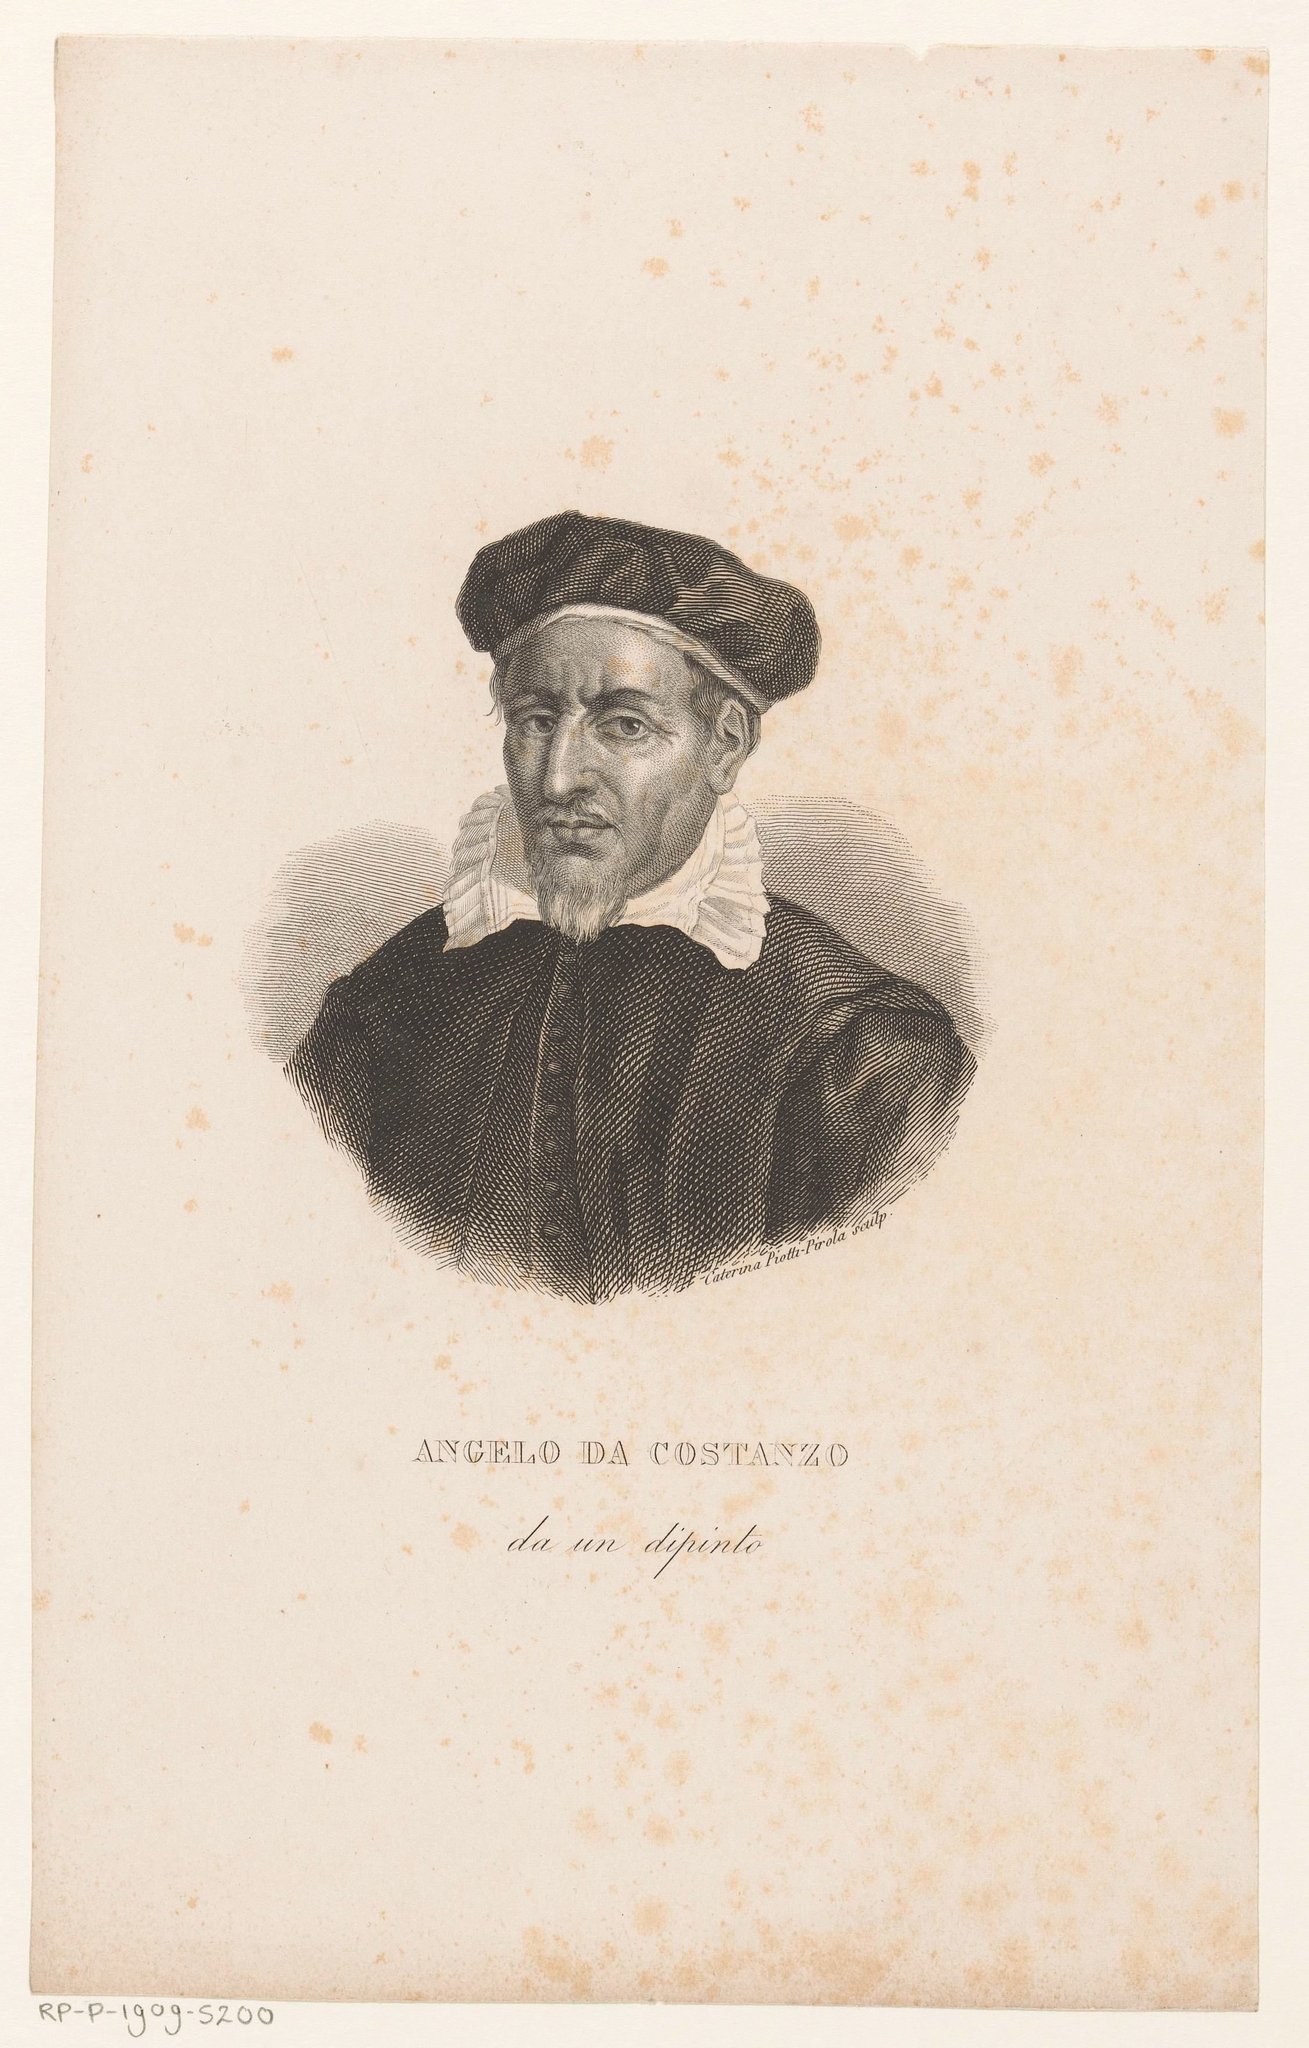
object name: print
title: Portret van dichter en historicus Angelo di Costanzo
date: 1810-1900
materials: paper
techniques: engraving, etching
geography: italy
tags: naples, historical persons, writer, poet, author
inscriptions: collector's mark: Lugt 2228